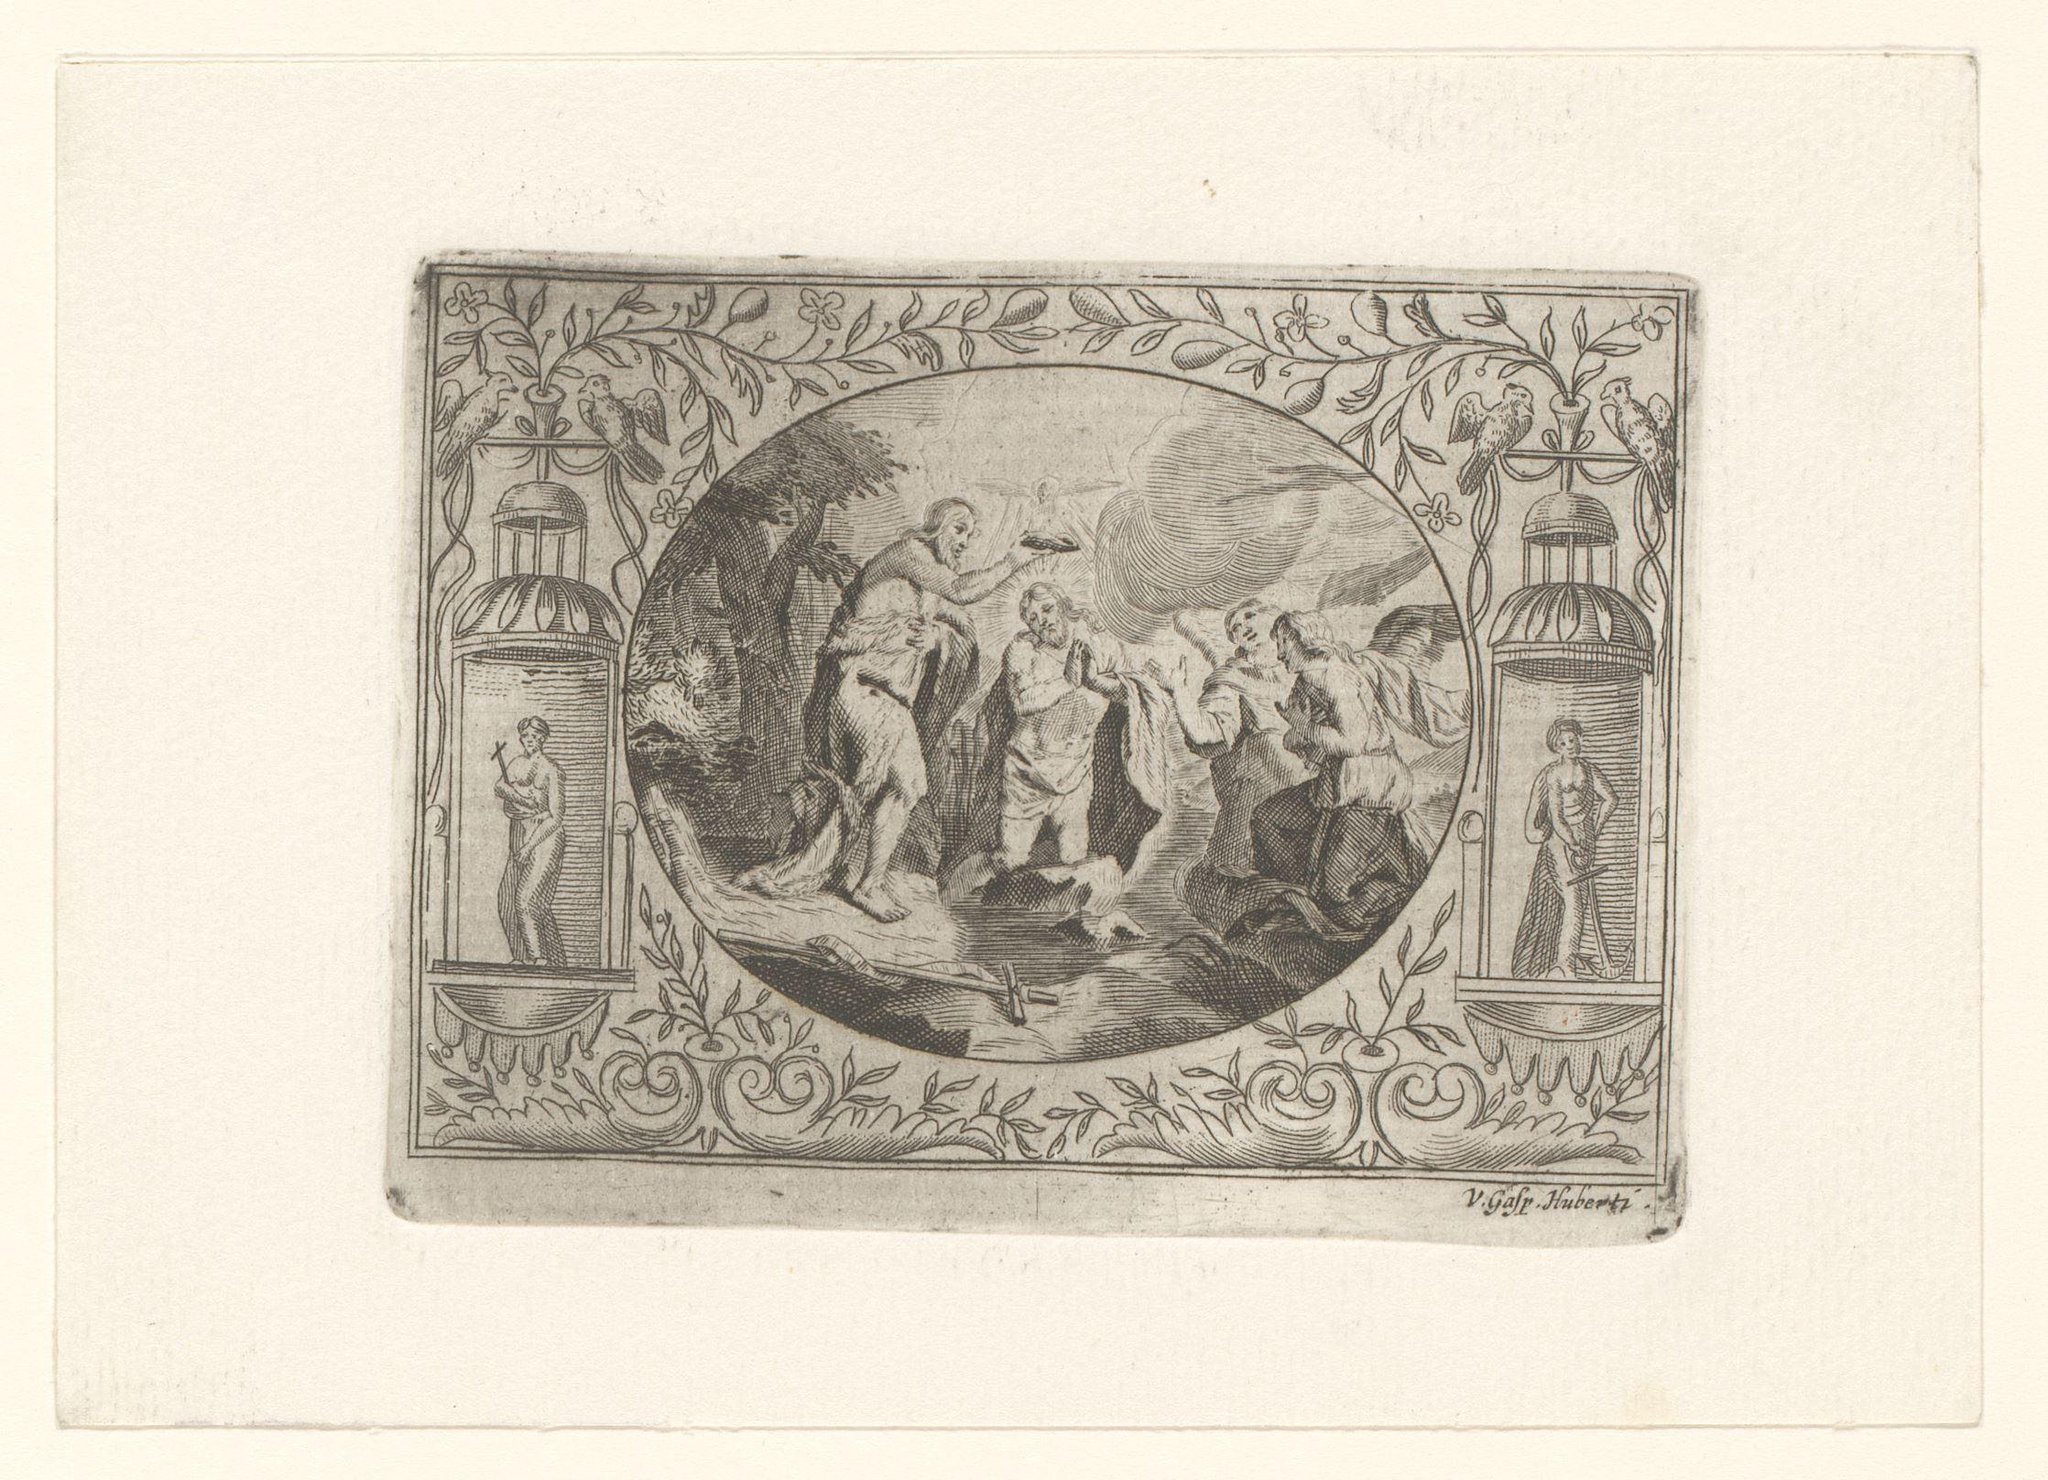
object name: print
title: Doop in de Jordaan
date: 1661-1684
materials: paper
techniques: engraving, etching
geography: antwerp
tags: baptism of christ in the river jordan: john the baptist pouring out water on christ's head: the holy ghost descends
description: De tweede vrouw van Gaspar Huybrechts zette na zijn dood het bedrijf voort onder de signatuur Vidua G. Huberti. Moderne druk van oorspronkelijke plaat.